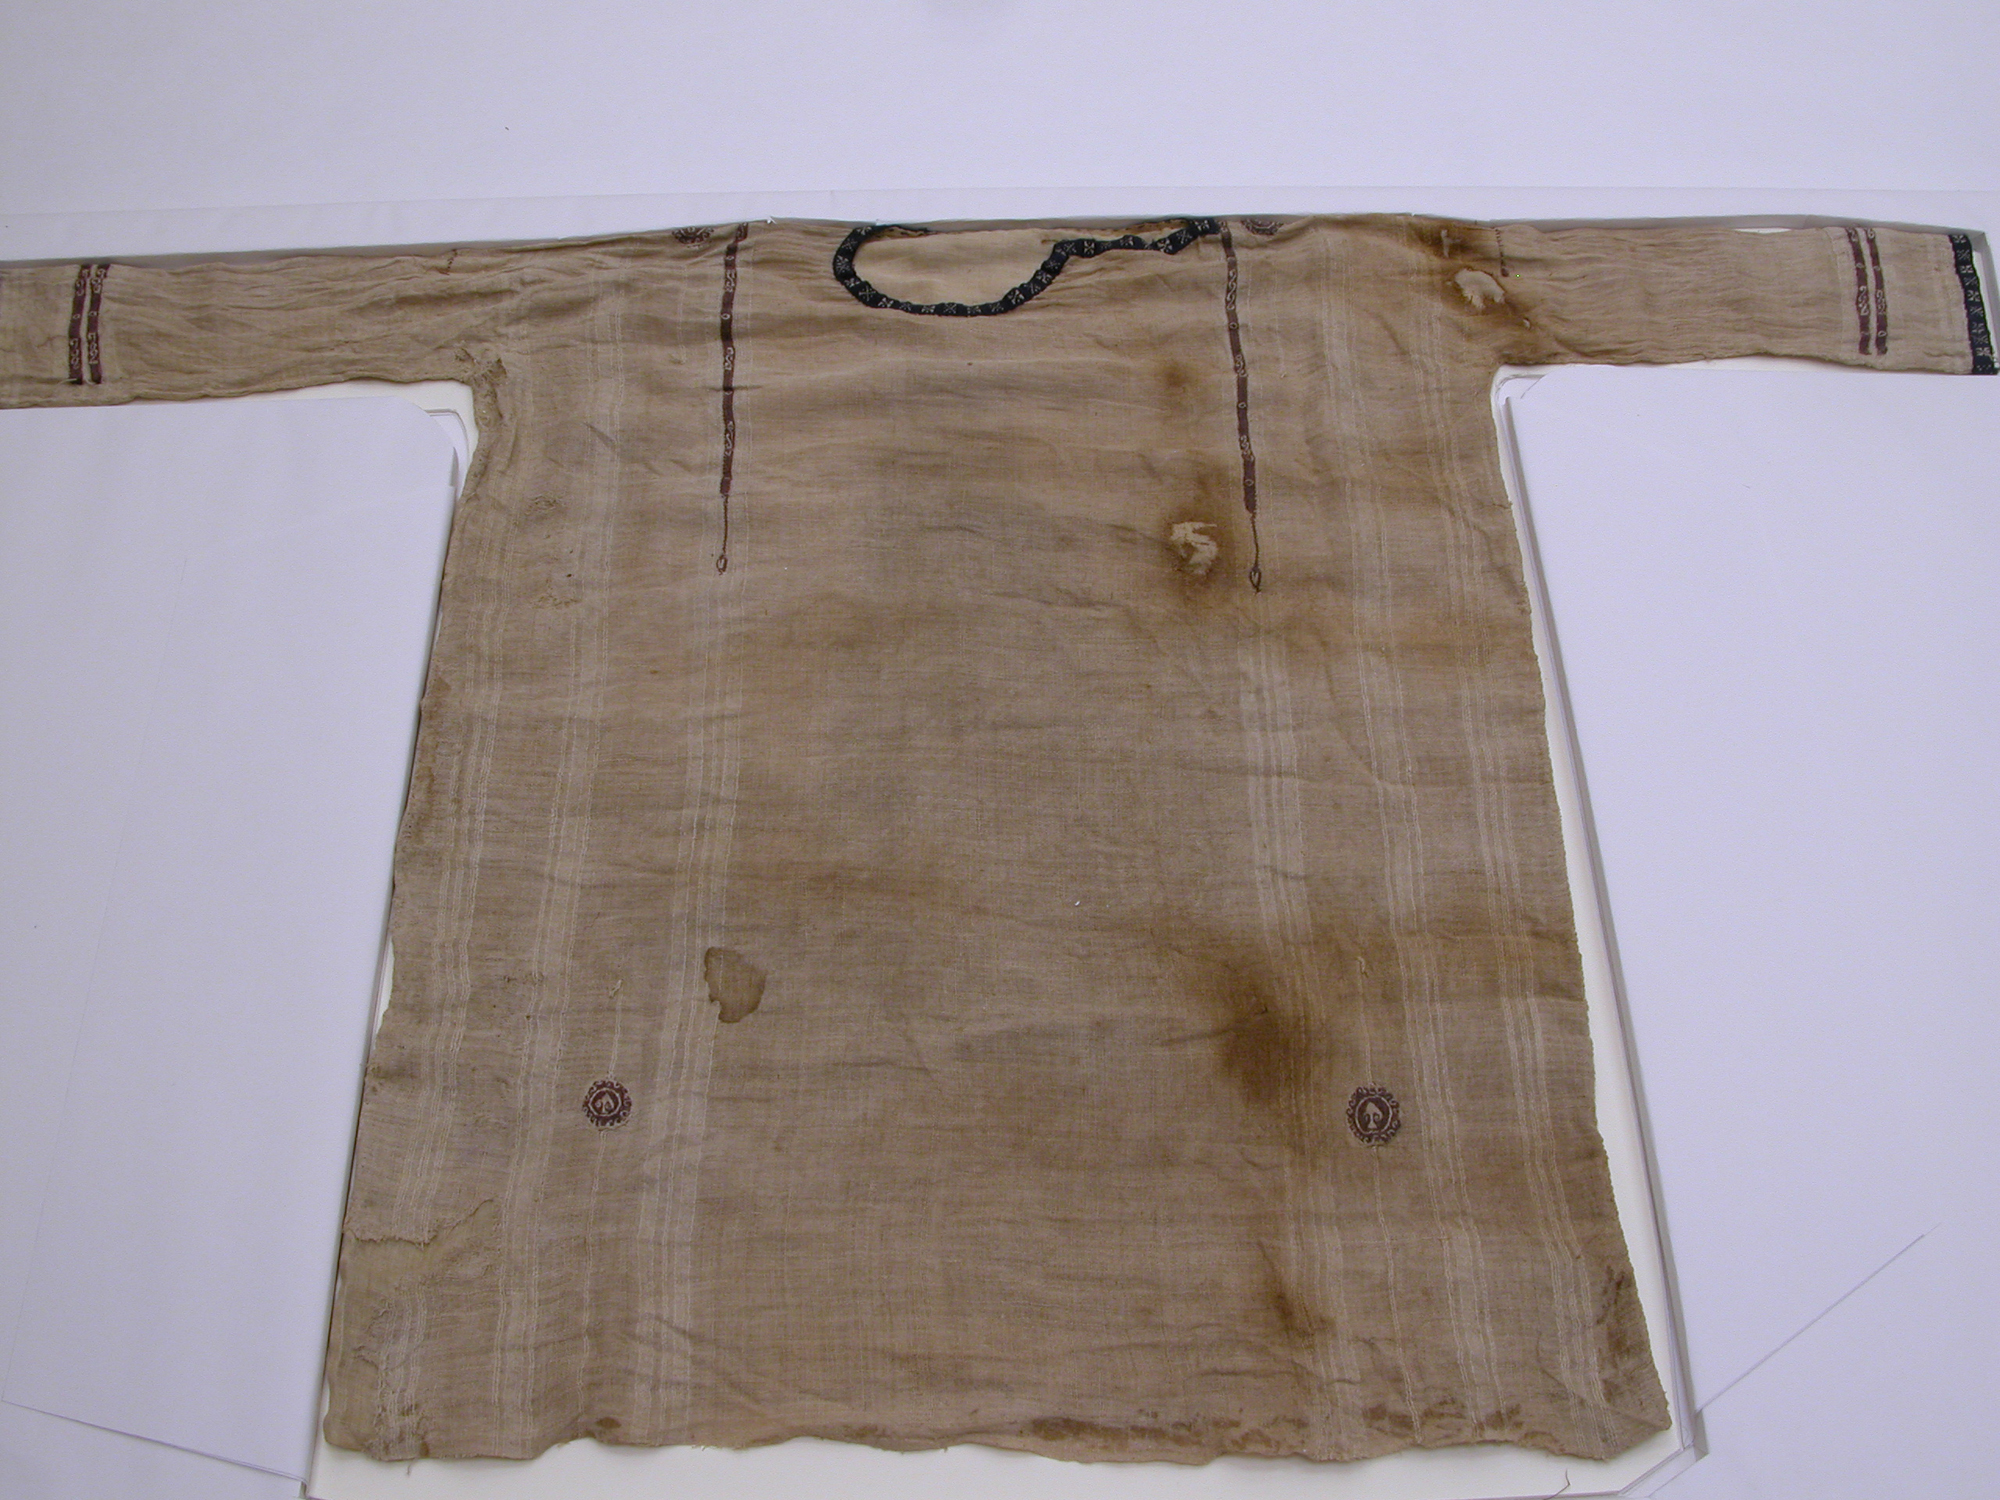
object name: tunic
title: Child's Tunic with Tapestry-Weave Ornament and Applied Bands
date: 501-900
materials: linen, wool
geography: egypt